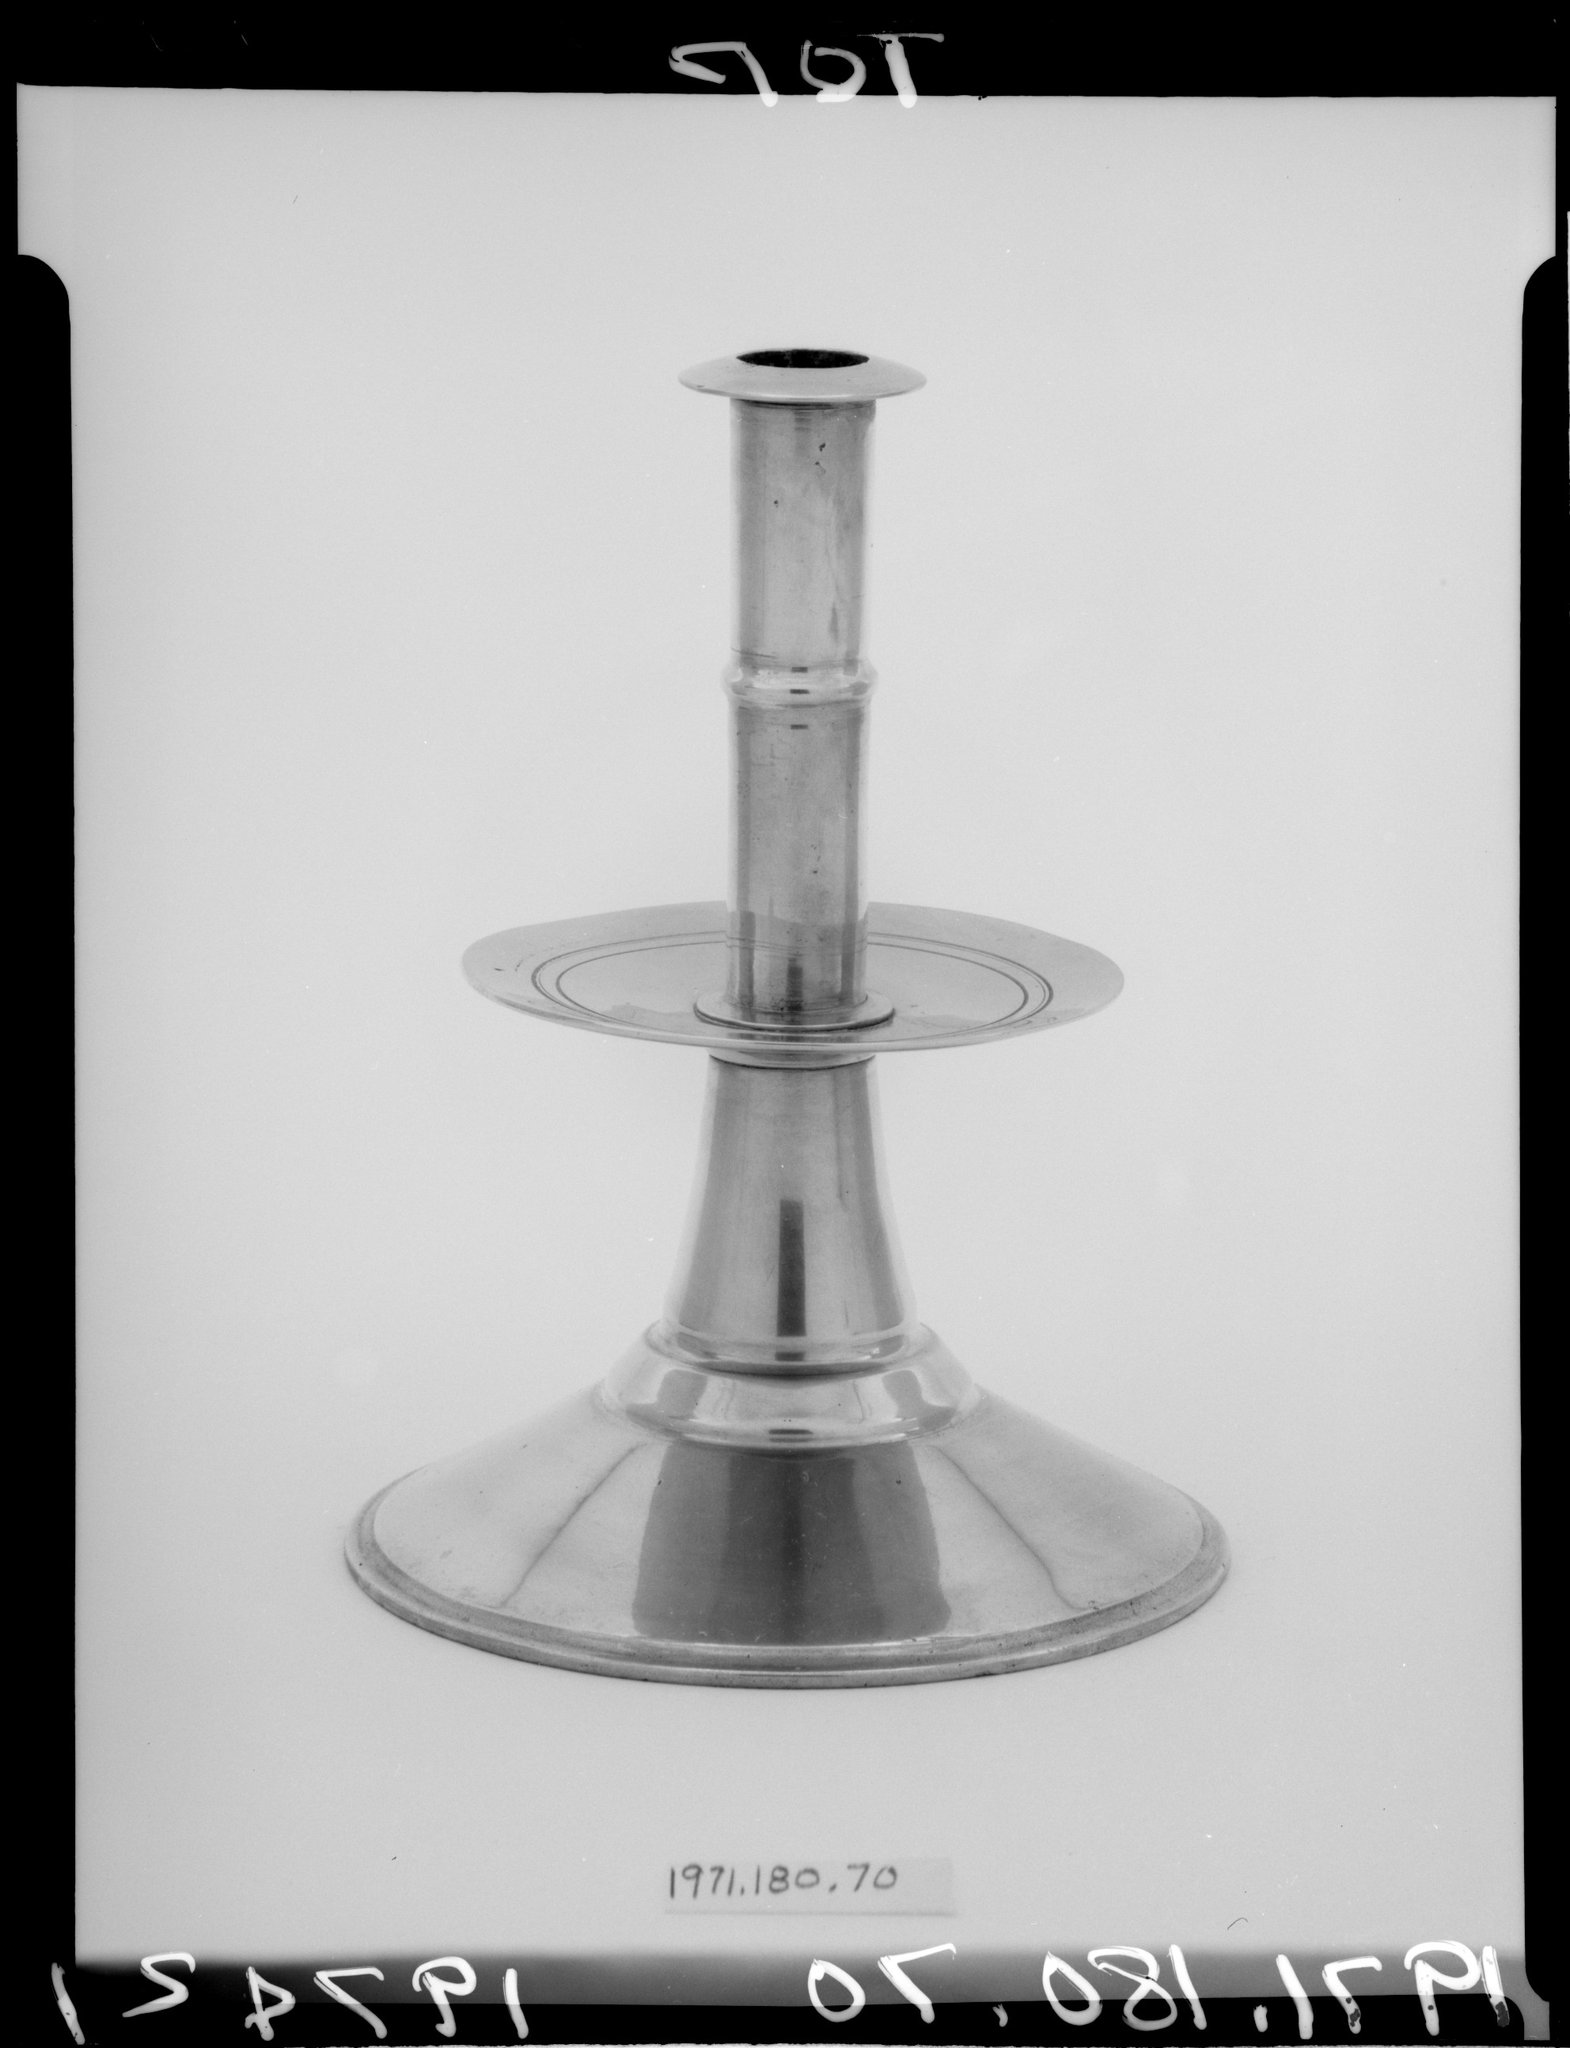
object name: candlestick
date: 1670-1700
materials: brass